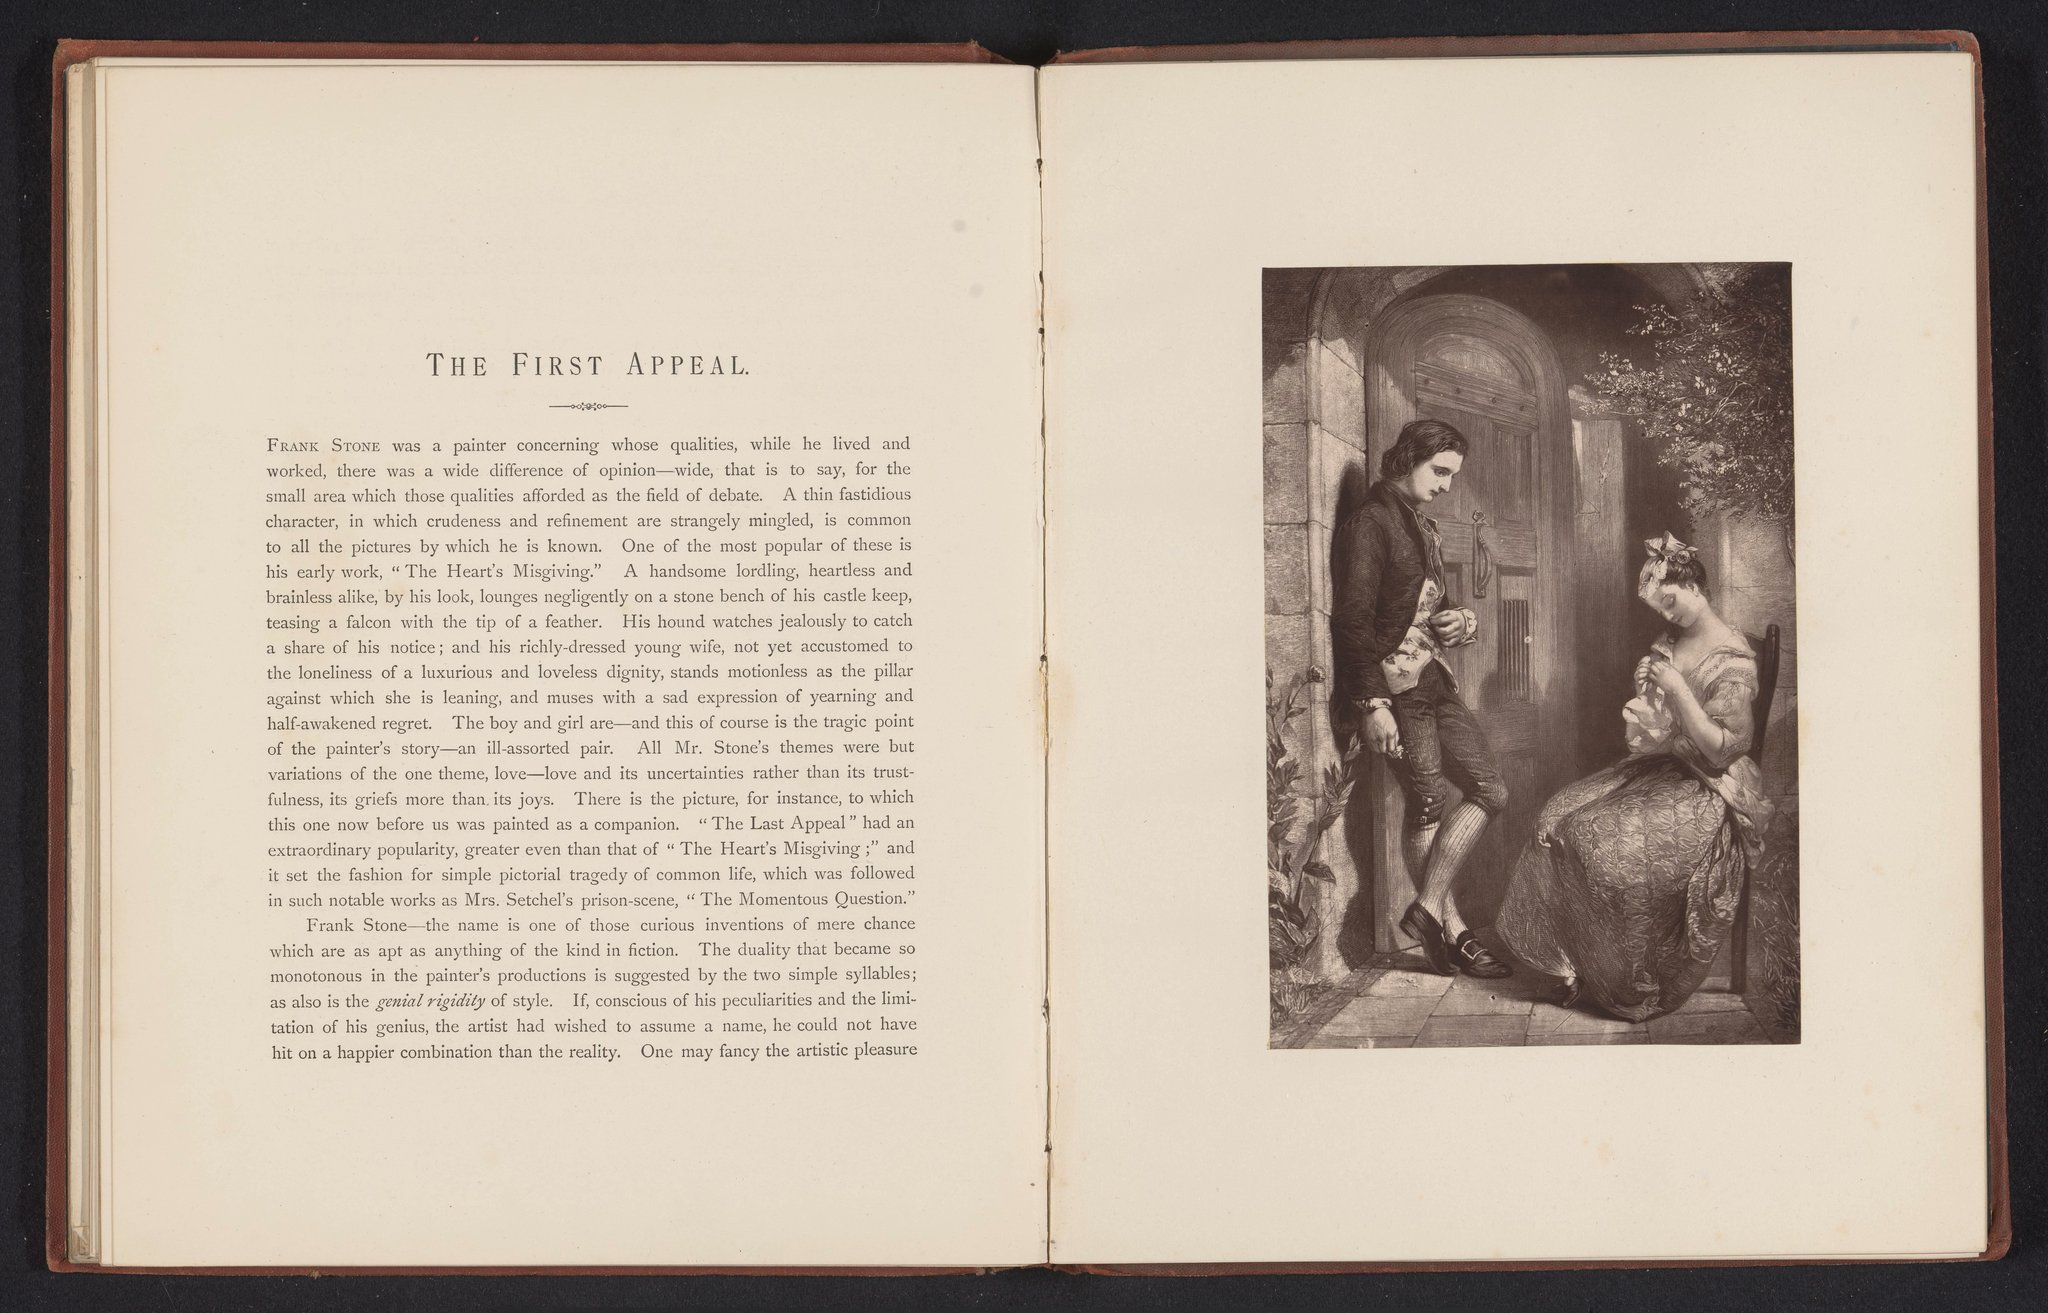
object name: photomechanical print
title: Fotoreproductie van een prent naar een schilderij, voorstellende een man en een handwerkende vrouw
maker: Anonymous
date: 1861-1871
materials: paper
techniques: woodburytype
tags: (other forms of) needlework, e.g.: crocheting, knitting, embroidering, lovers; courting, flirting